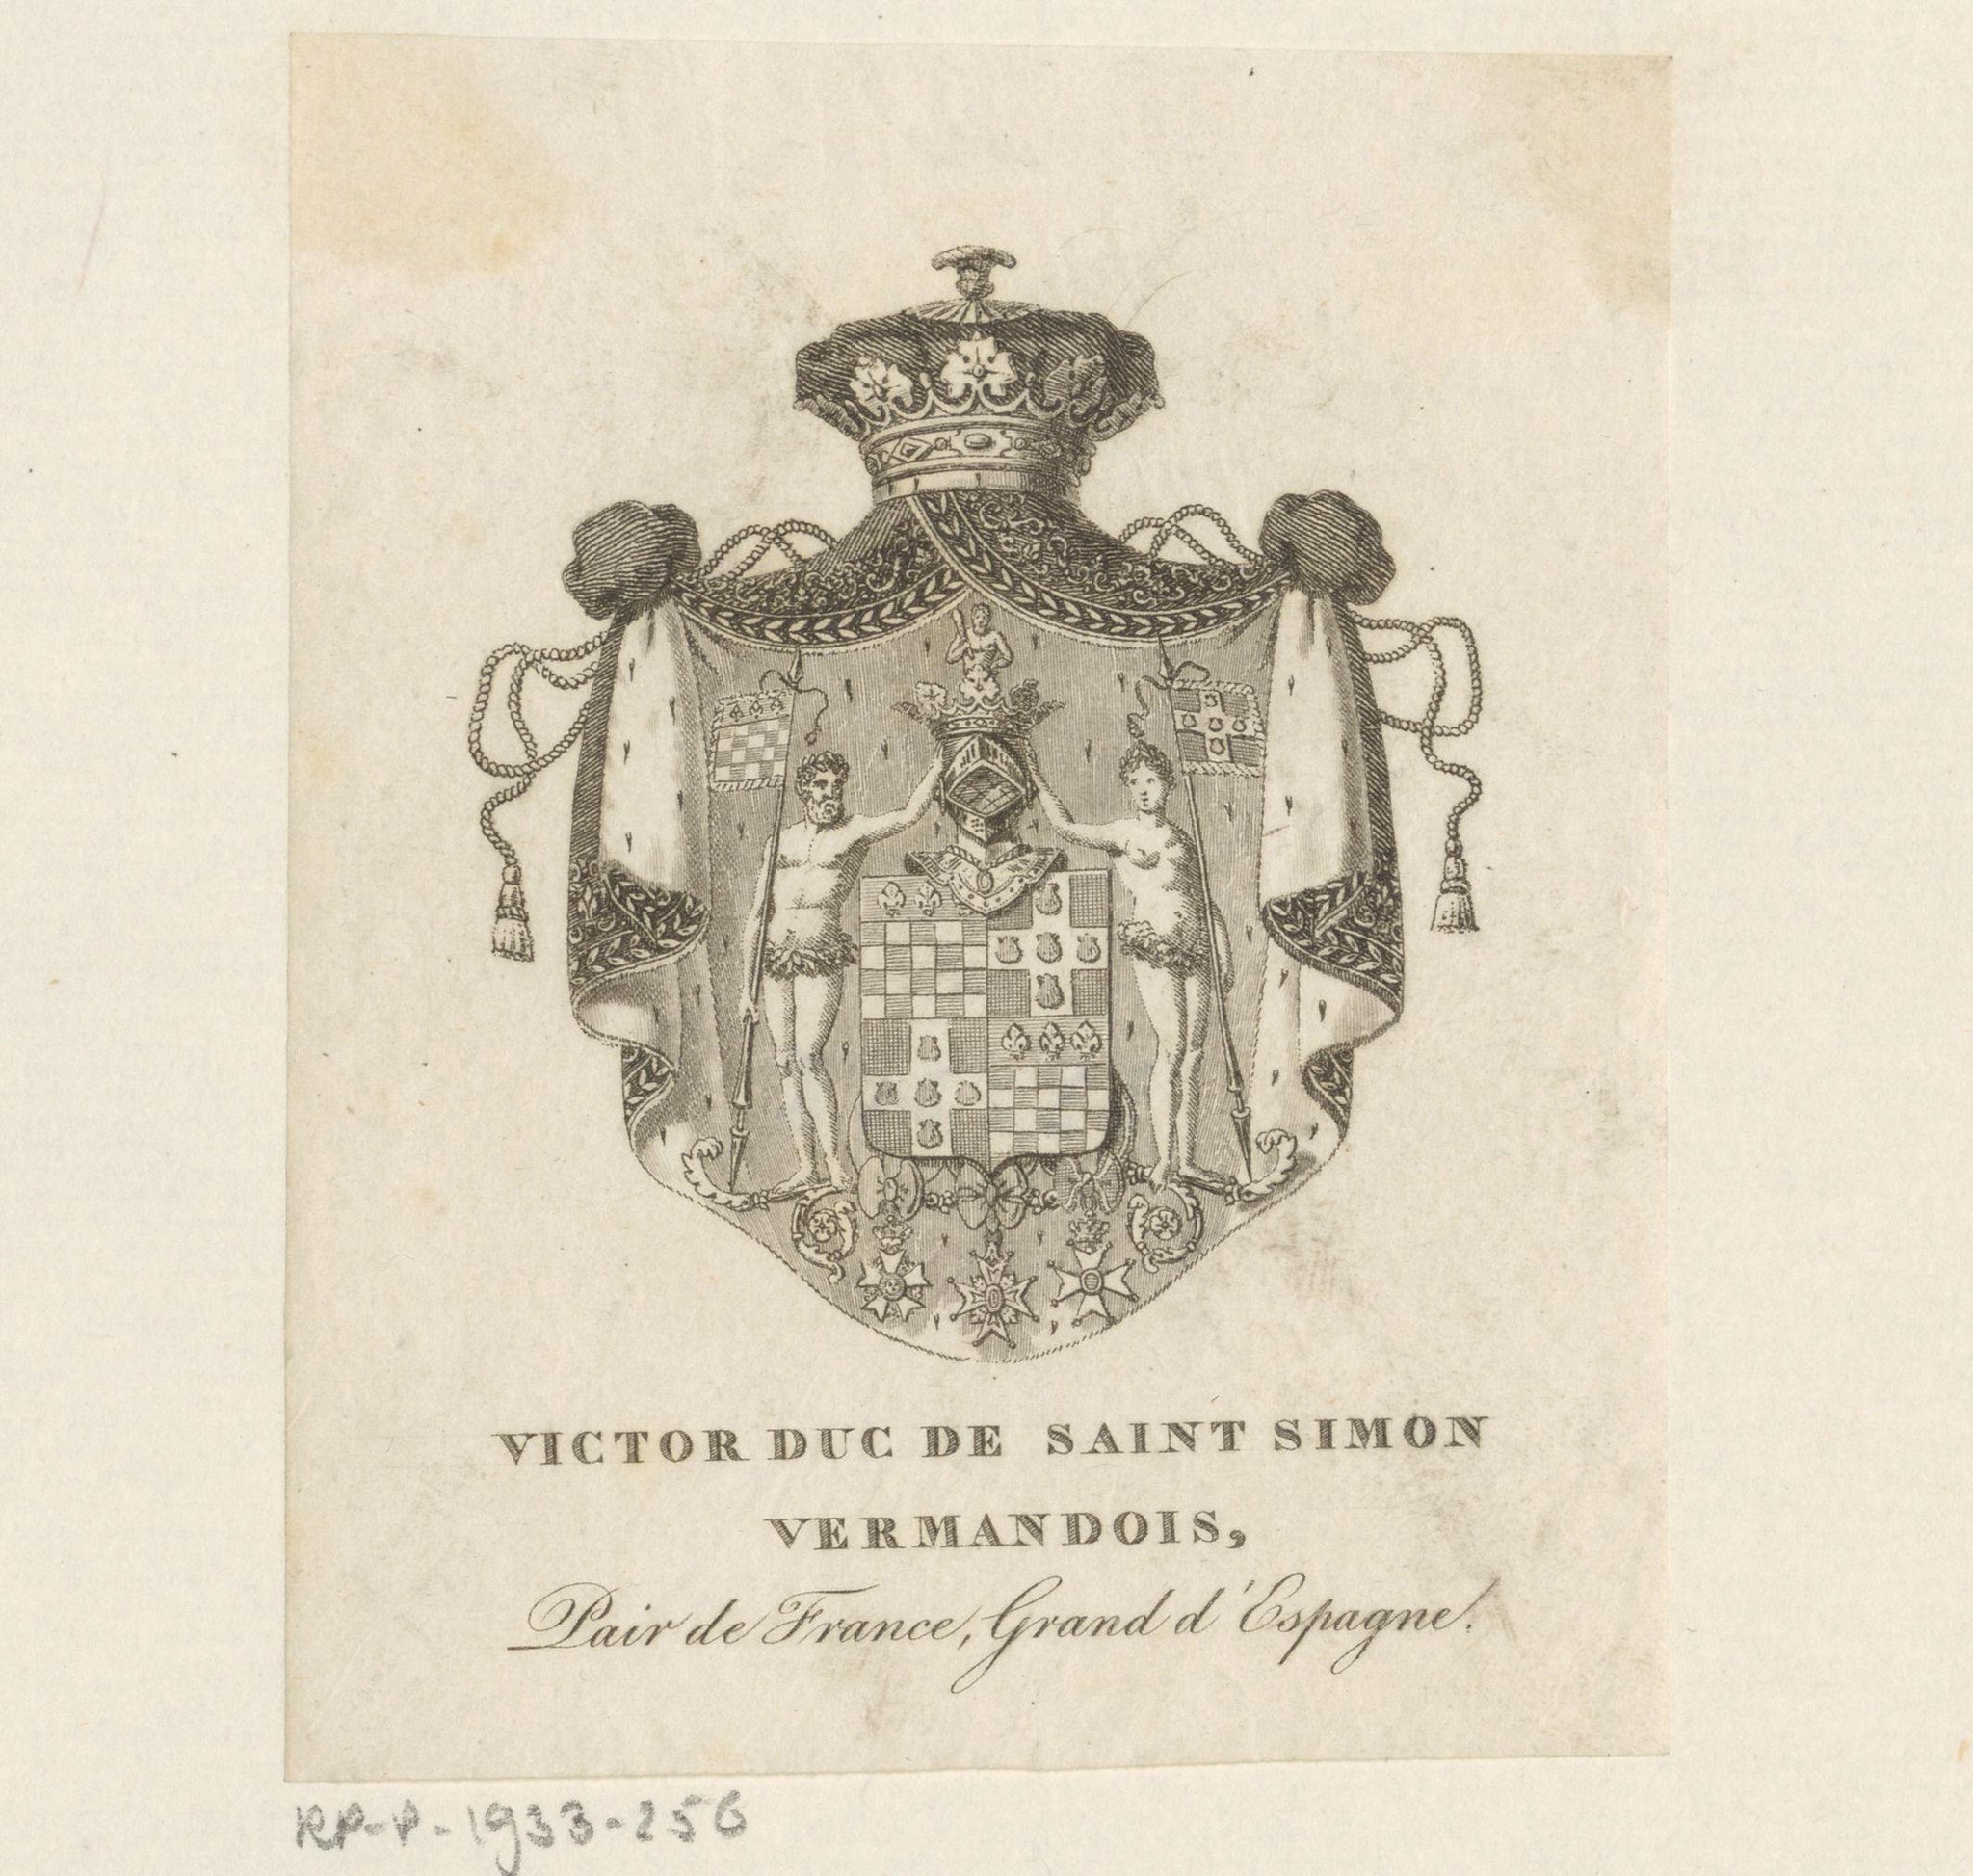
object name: bookplate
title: Ex libris van Victor de Rouvroy de Saint-Simon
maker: Anonymous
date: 1819-1865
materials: paper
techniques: etching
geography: france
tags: politician, standing figure, armorial bearing, heraldry, man (showing himself) undressed, quasi-nude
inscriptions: collector's mark: Lugt 2760